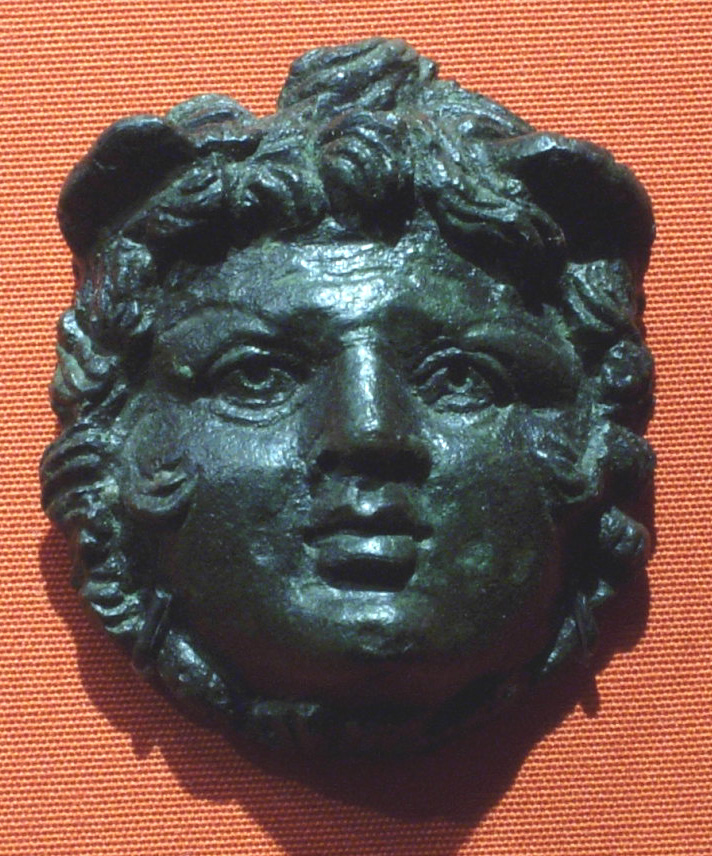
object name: attachment, head of medusa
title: Decorative attachment in the form of a head of Medusa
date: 101-200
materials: bronze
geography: egypt